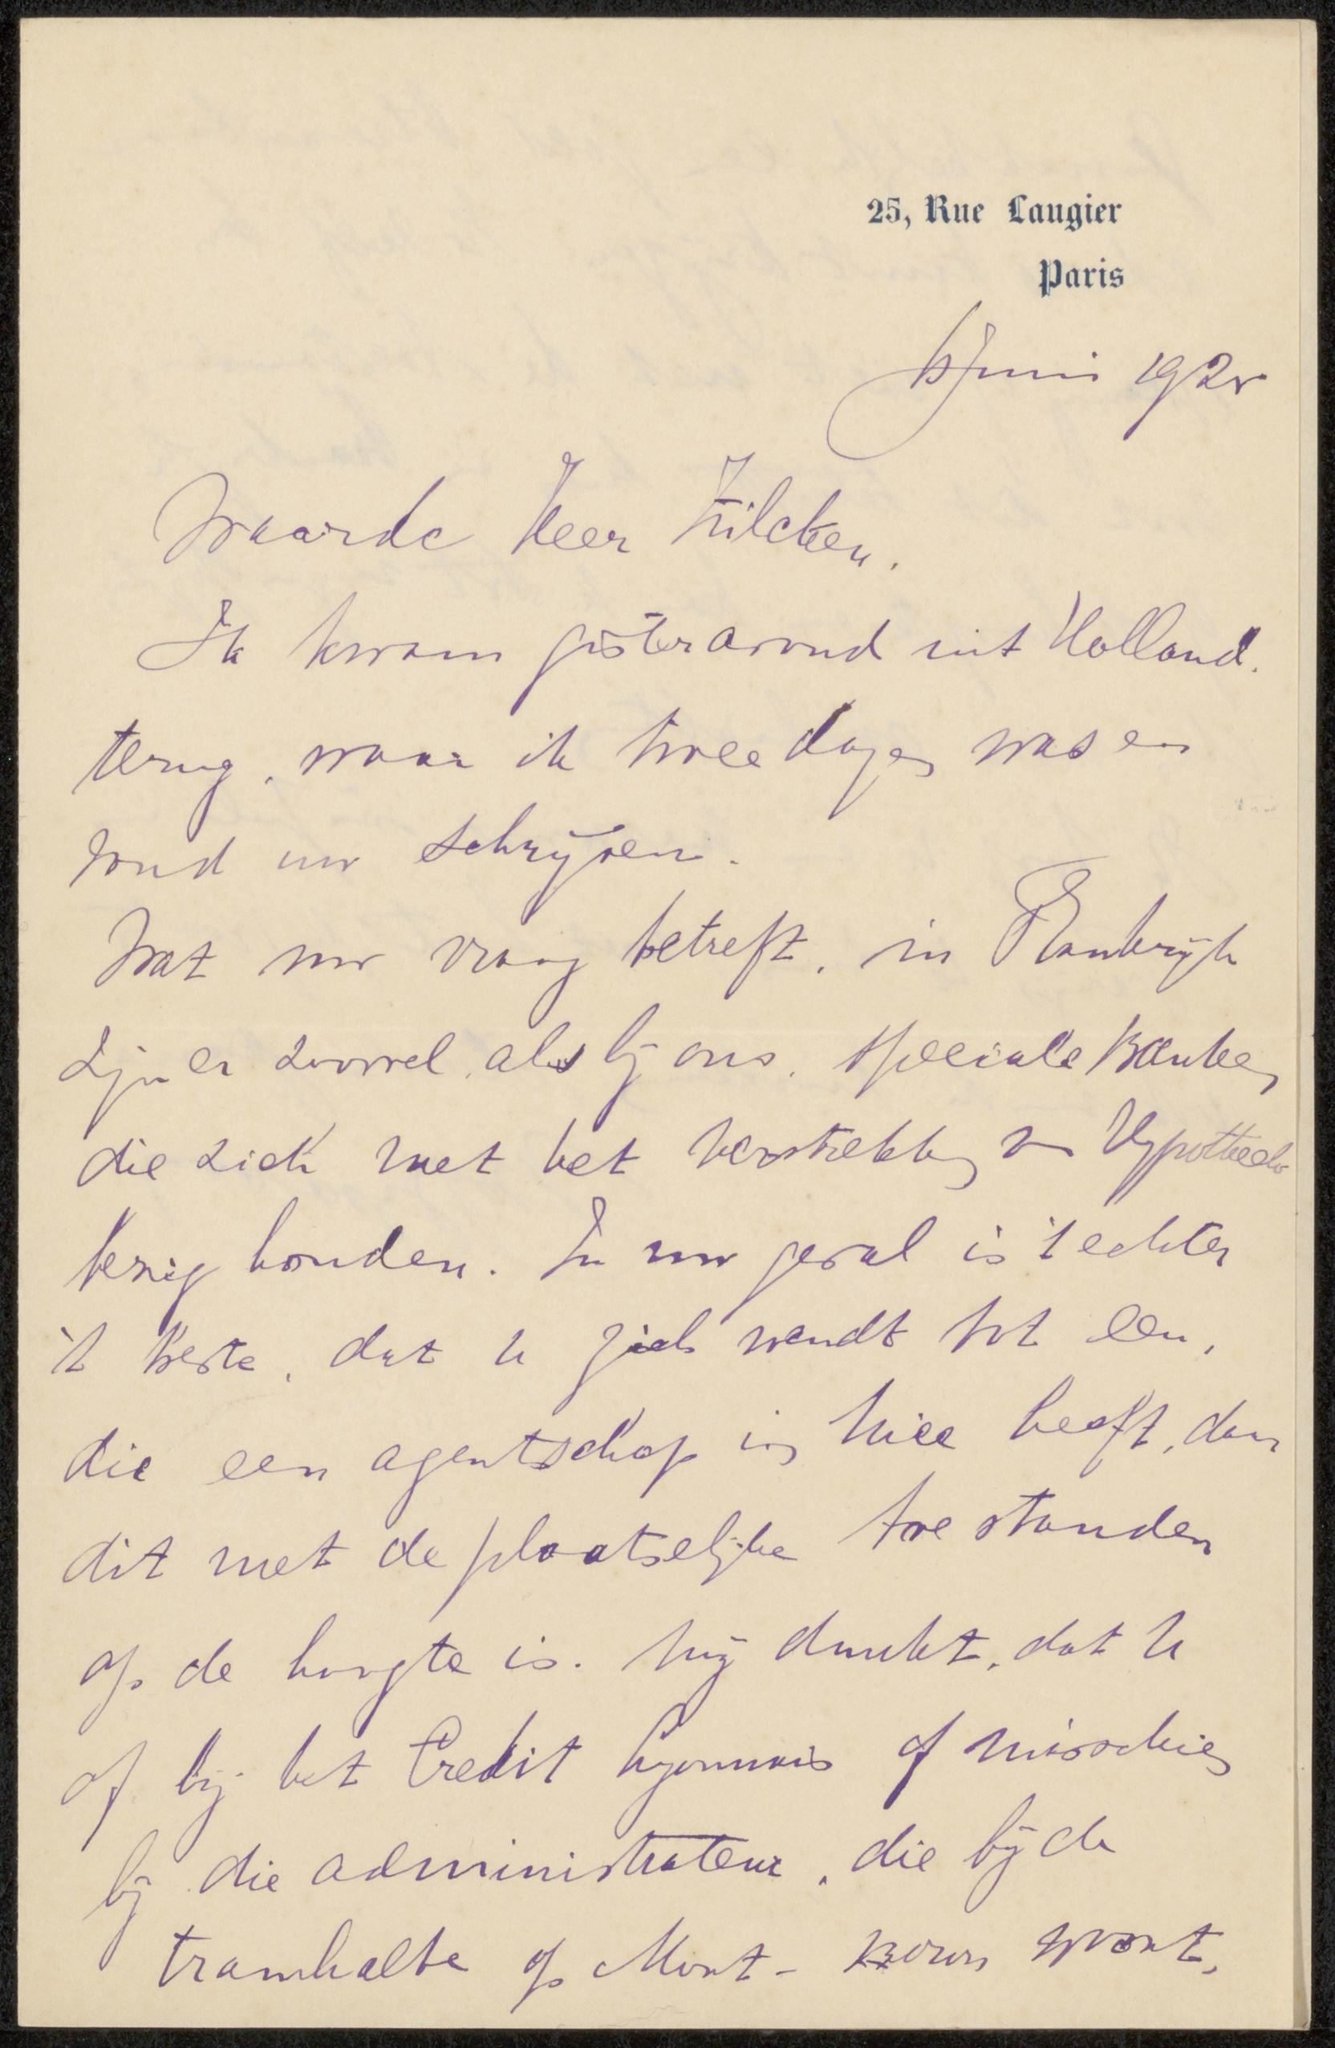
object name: letter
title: Brief aan Philip Zilcken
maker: selma boasson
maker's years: 1884-1924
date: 1924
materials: ink, paper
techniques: pen, writing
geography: paris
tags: paris, painter, draughtsman, etienne dinet, the hague, philip zilcken, france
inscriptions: collector's mark: ‘RPK’